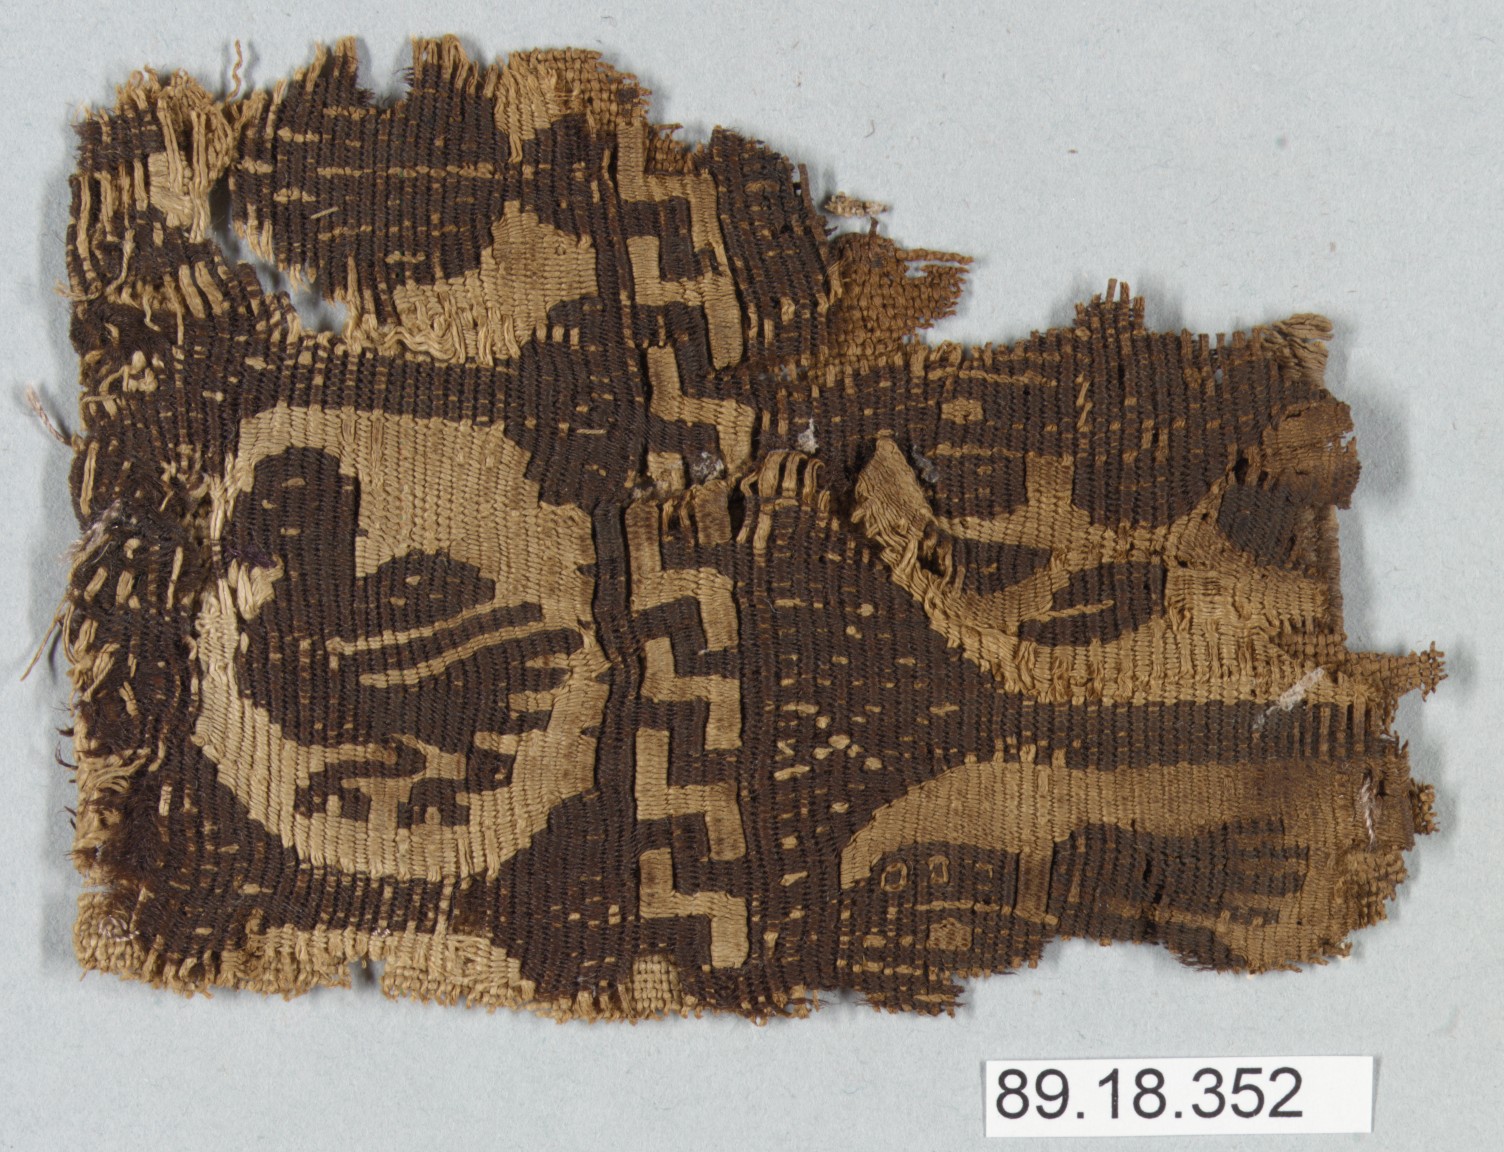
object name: textile fragment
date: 201-400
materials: linen, wool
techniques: weave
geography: egypt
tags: birds